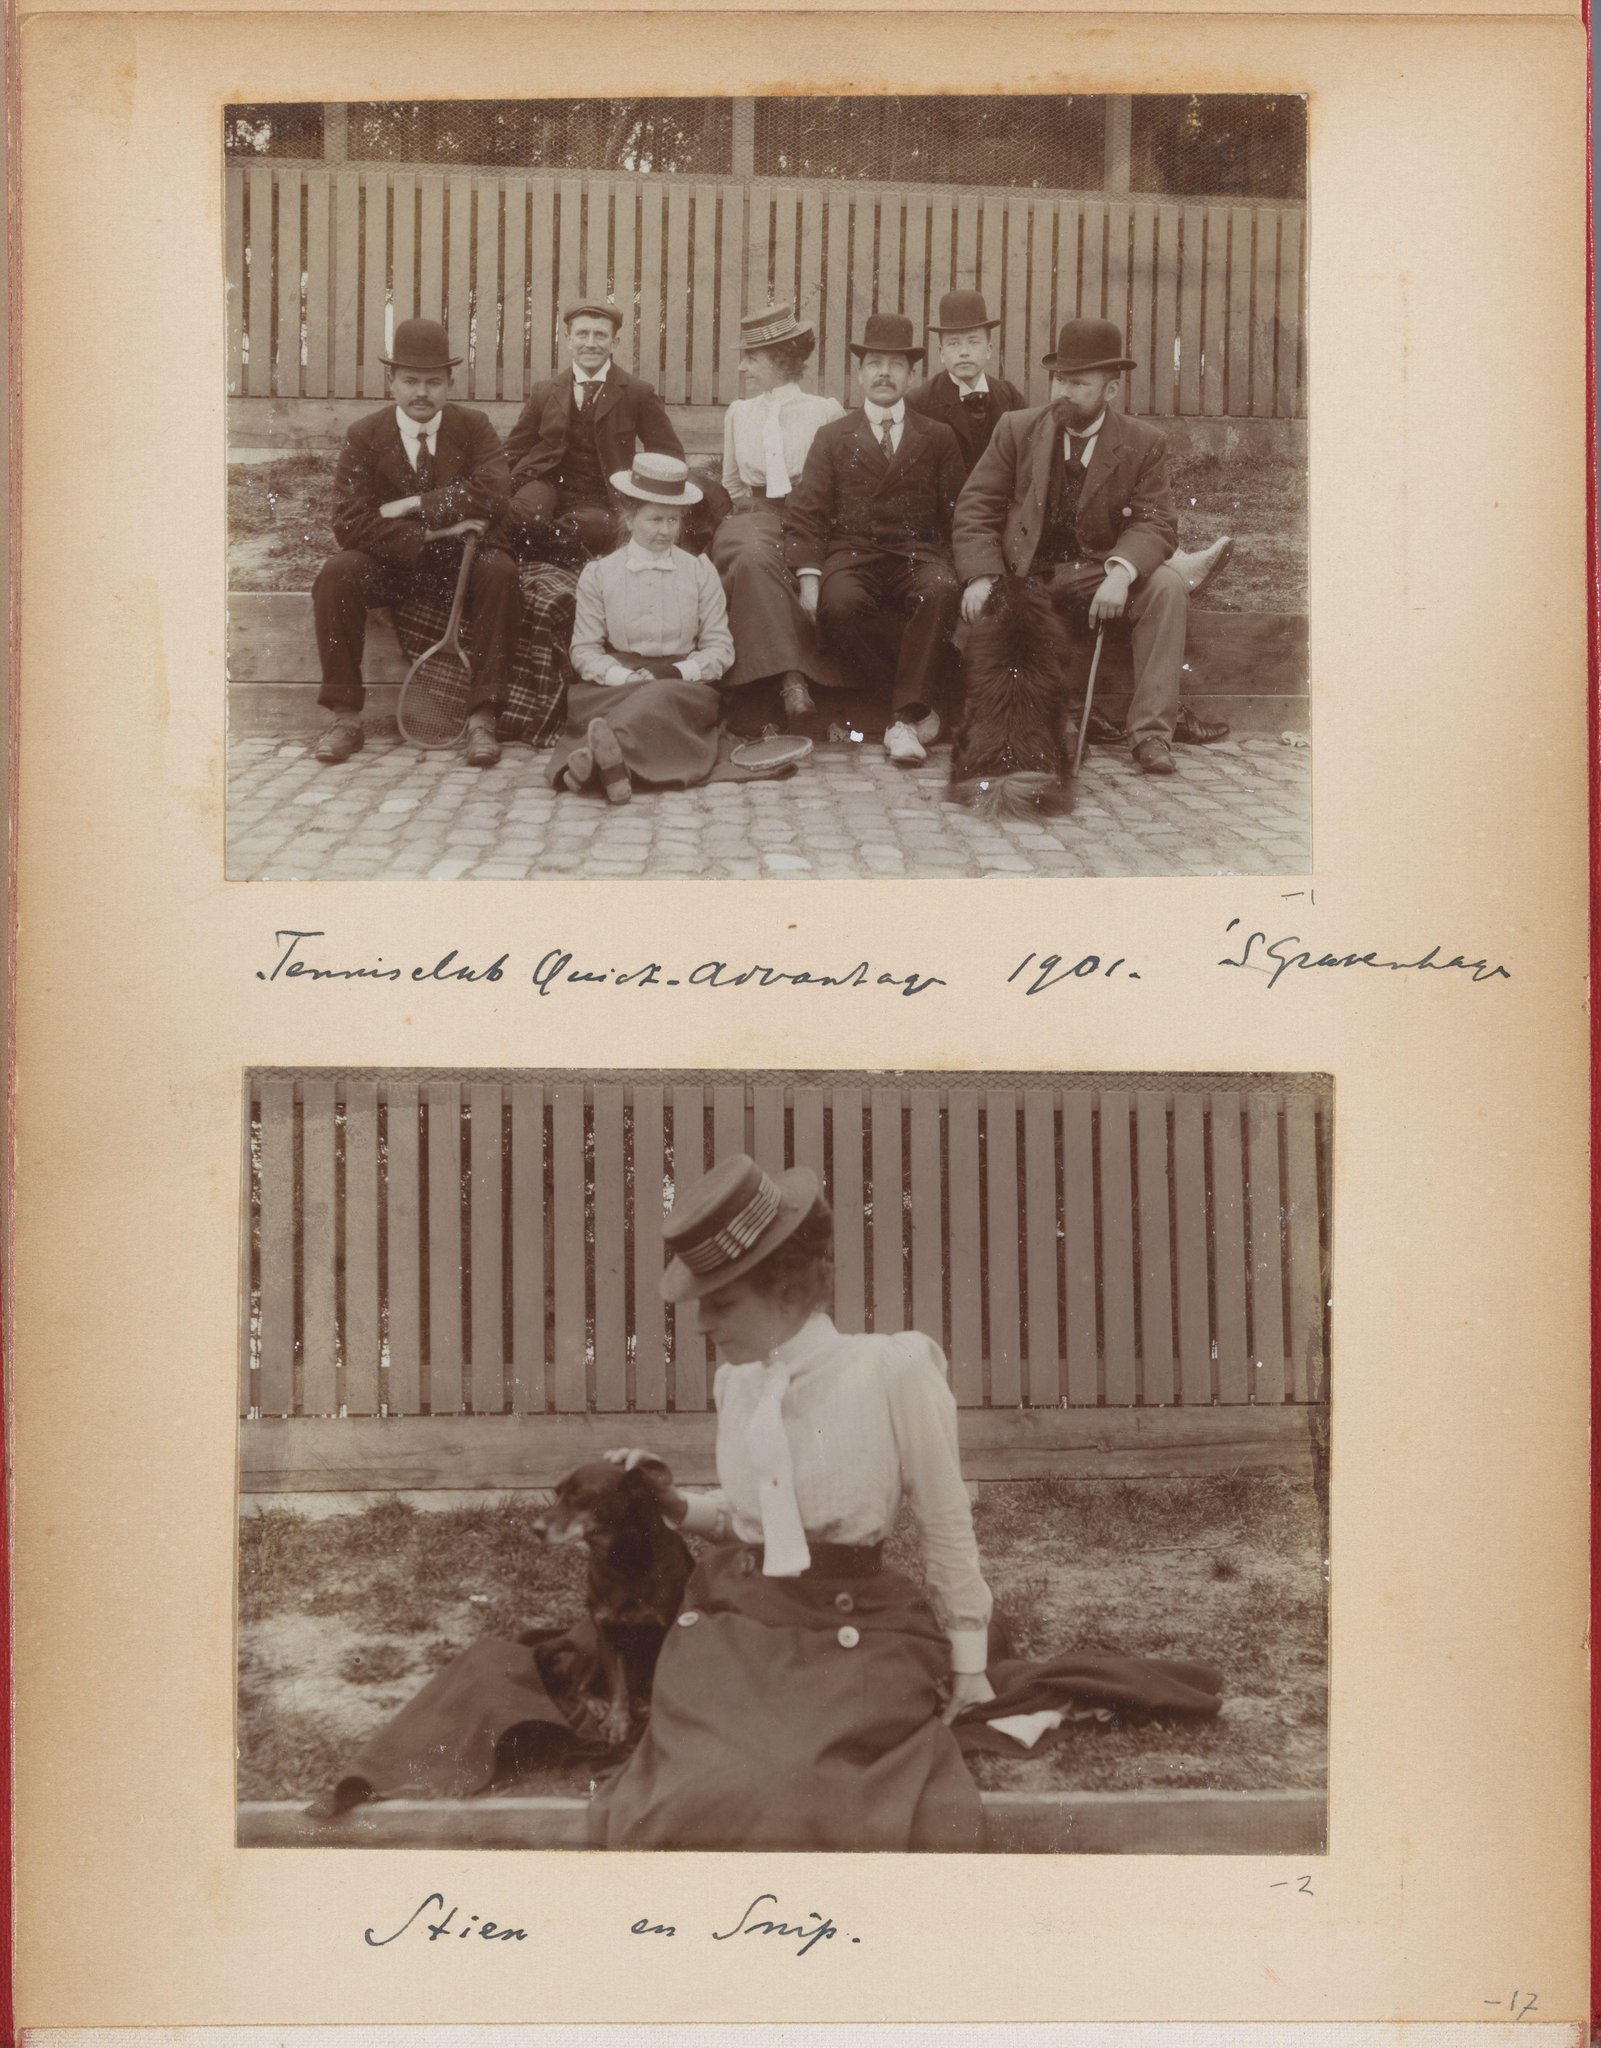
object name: photograph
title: Groepje leden van Tennisclub Quick Advantage 1901 in Den Haag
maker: gerard aalbersberg (us)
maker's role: amateurfotograaf, arts, chirurg, gynaecoloog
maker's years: 1870-1934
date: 1901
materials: paper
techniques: collodion silver print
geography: the hague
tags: the hague